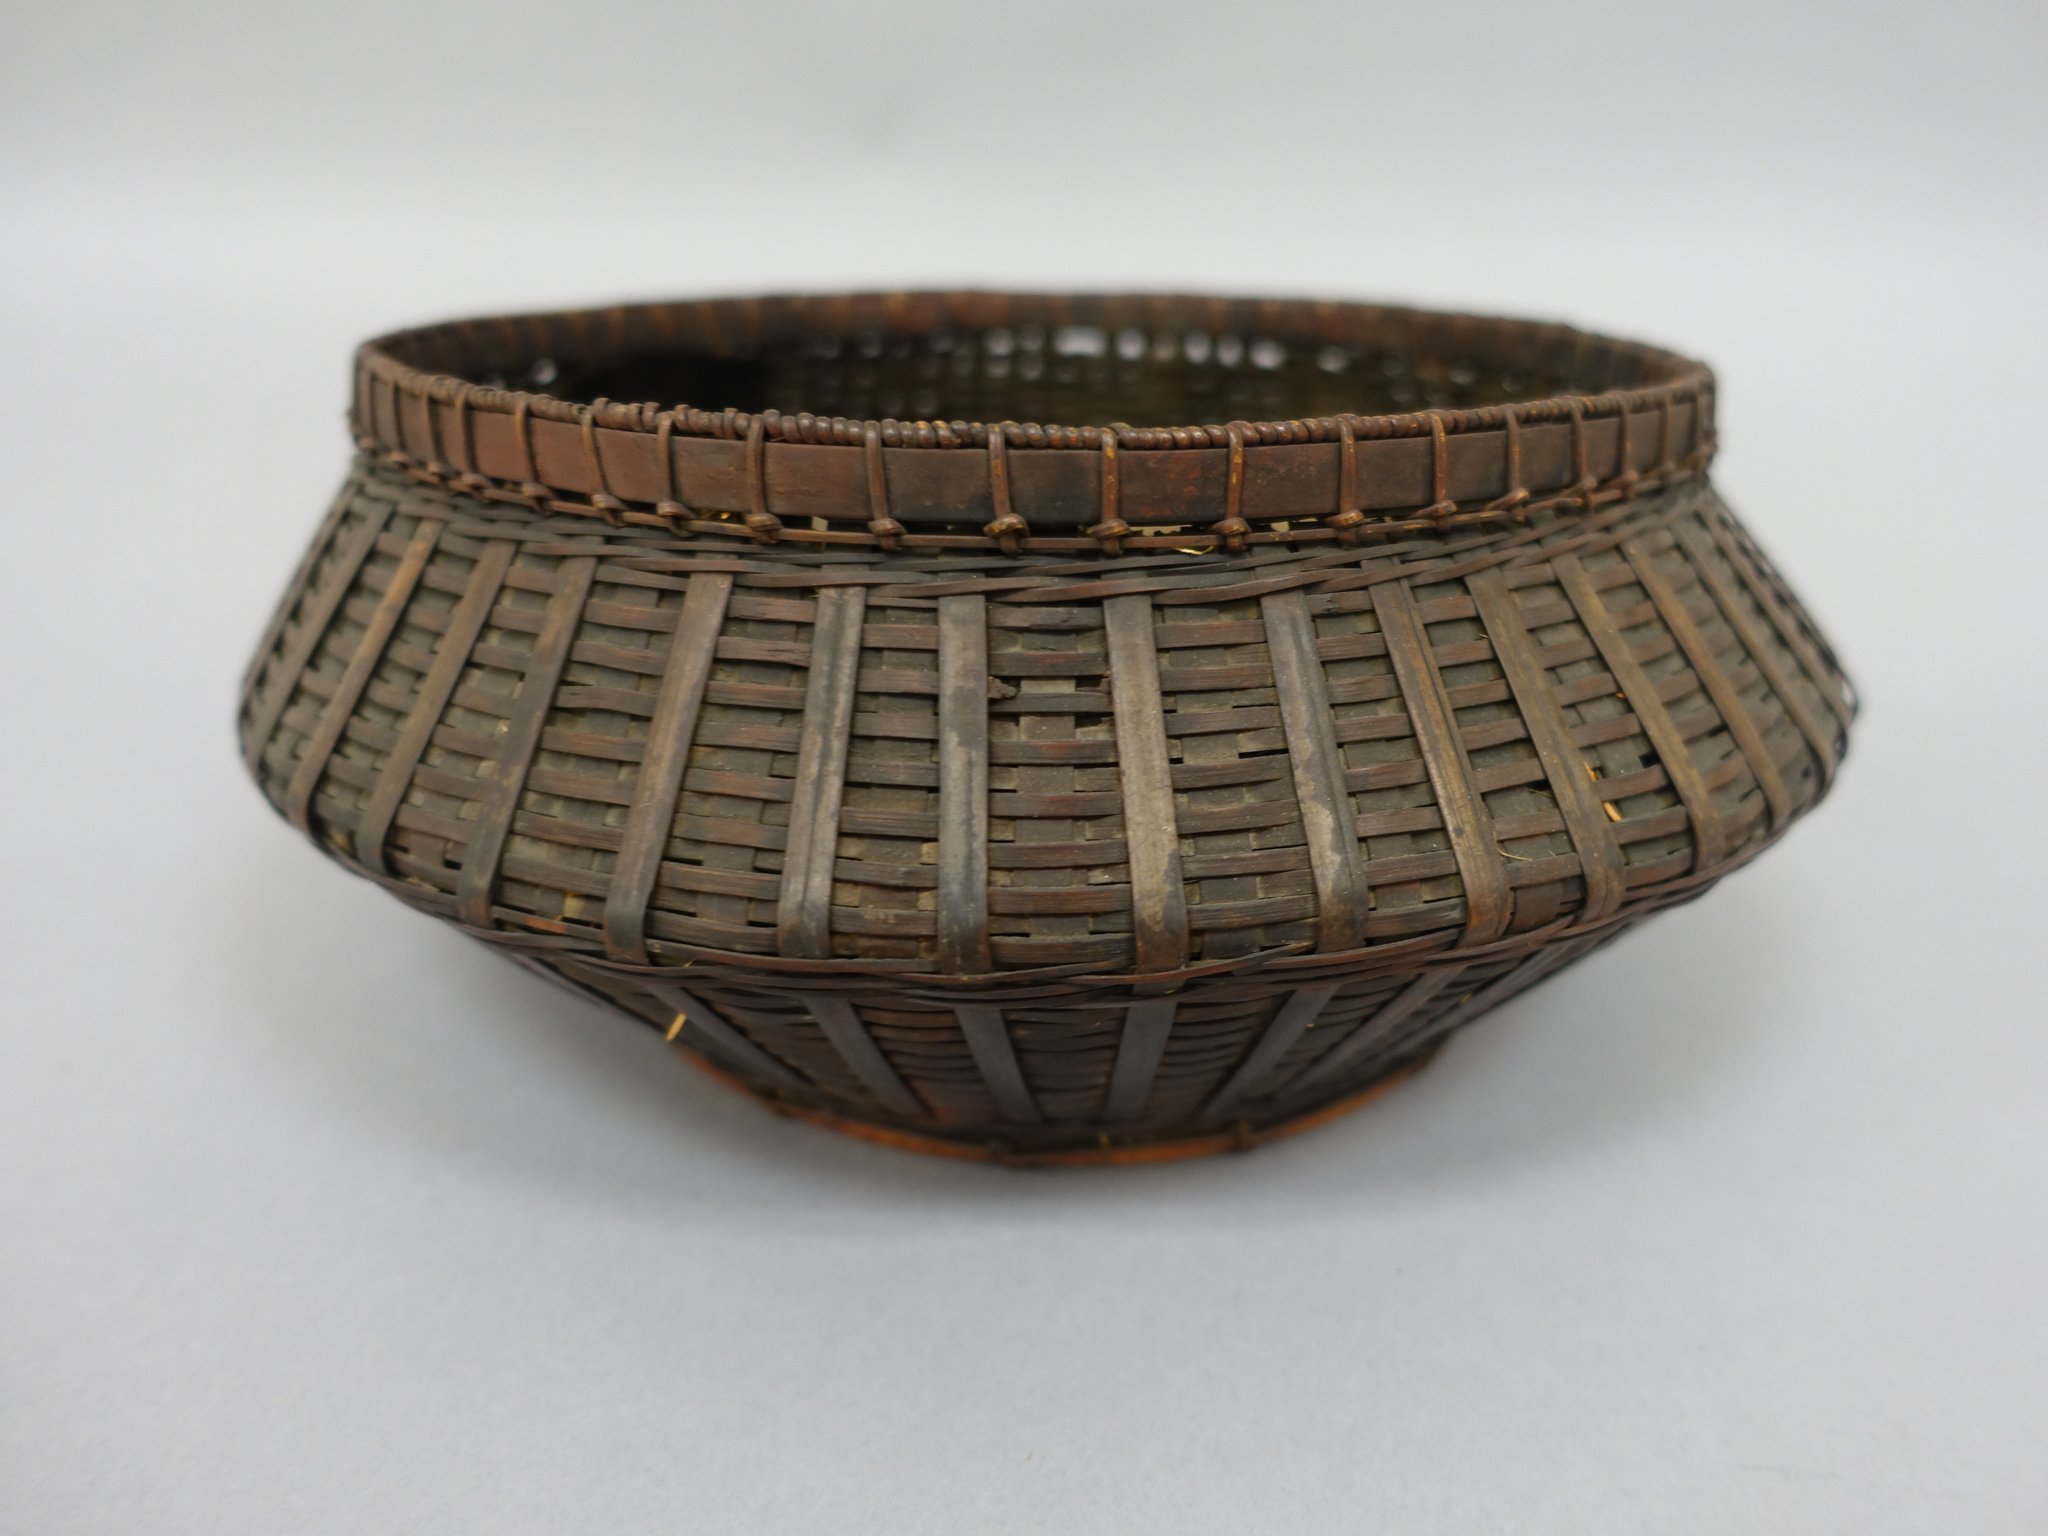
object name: basket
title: Charcoal Basket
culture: japanese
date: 1801-1900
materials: bamboo